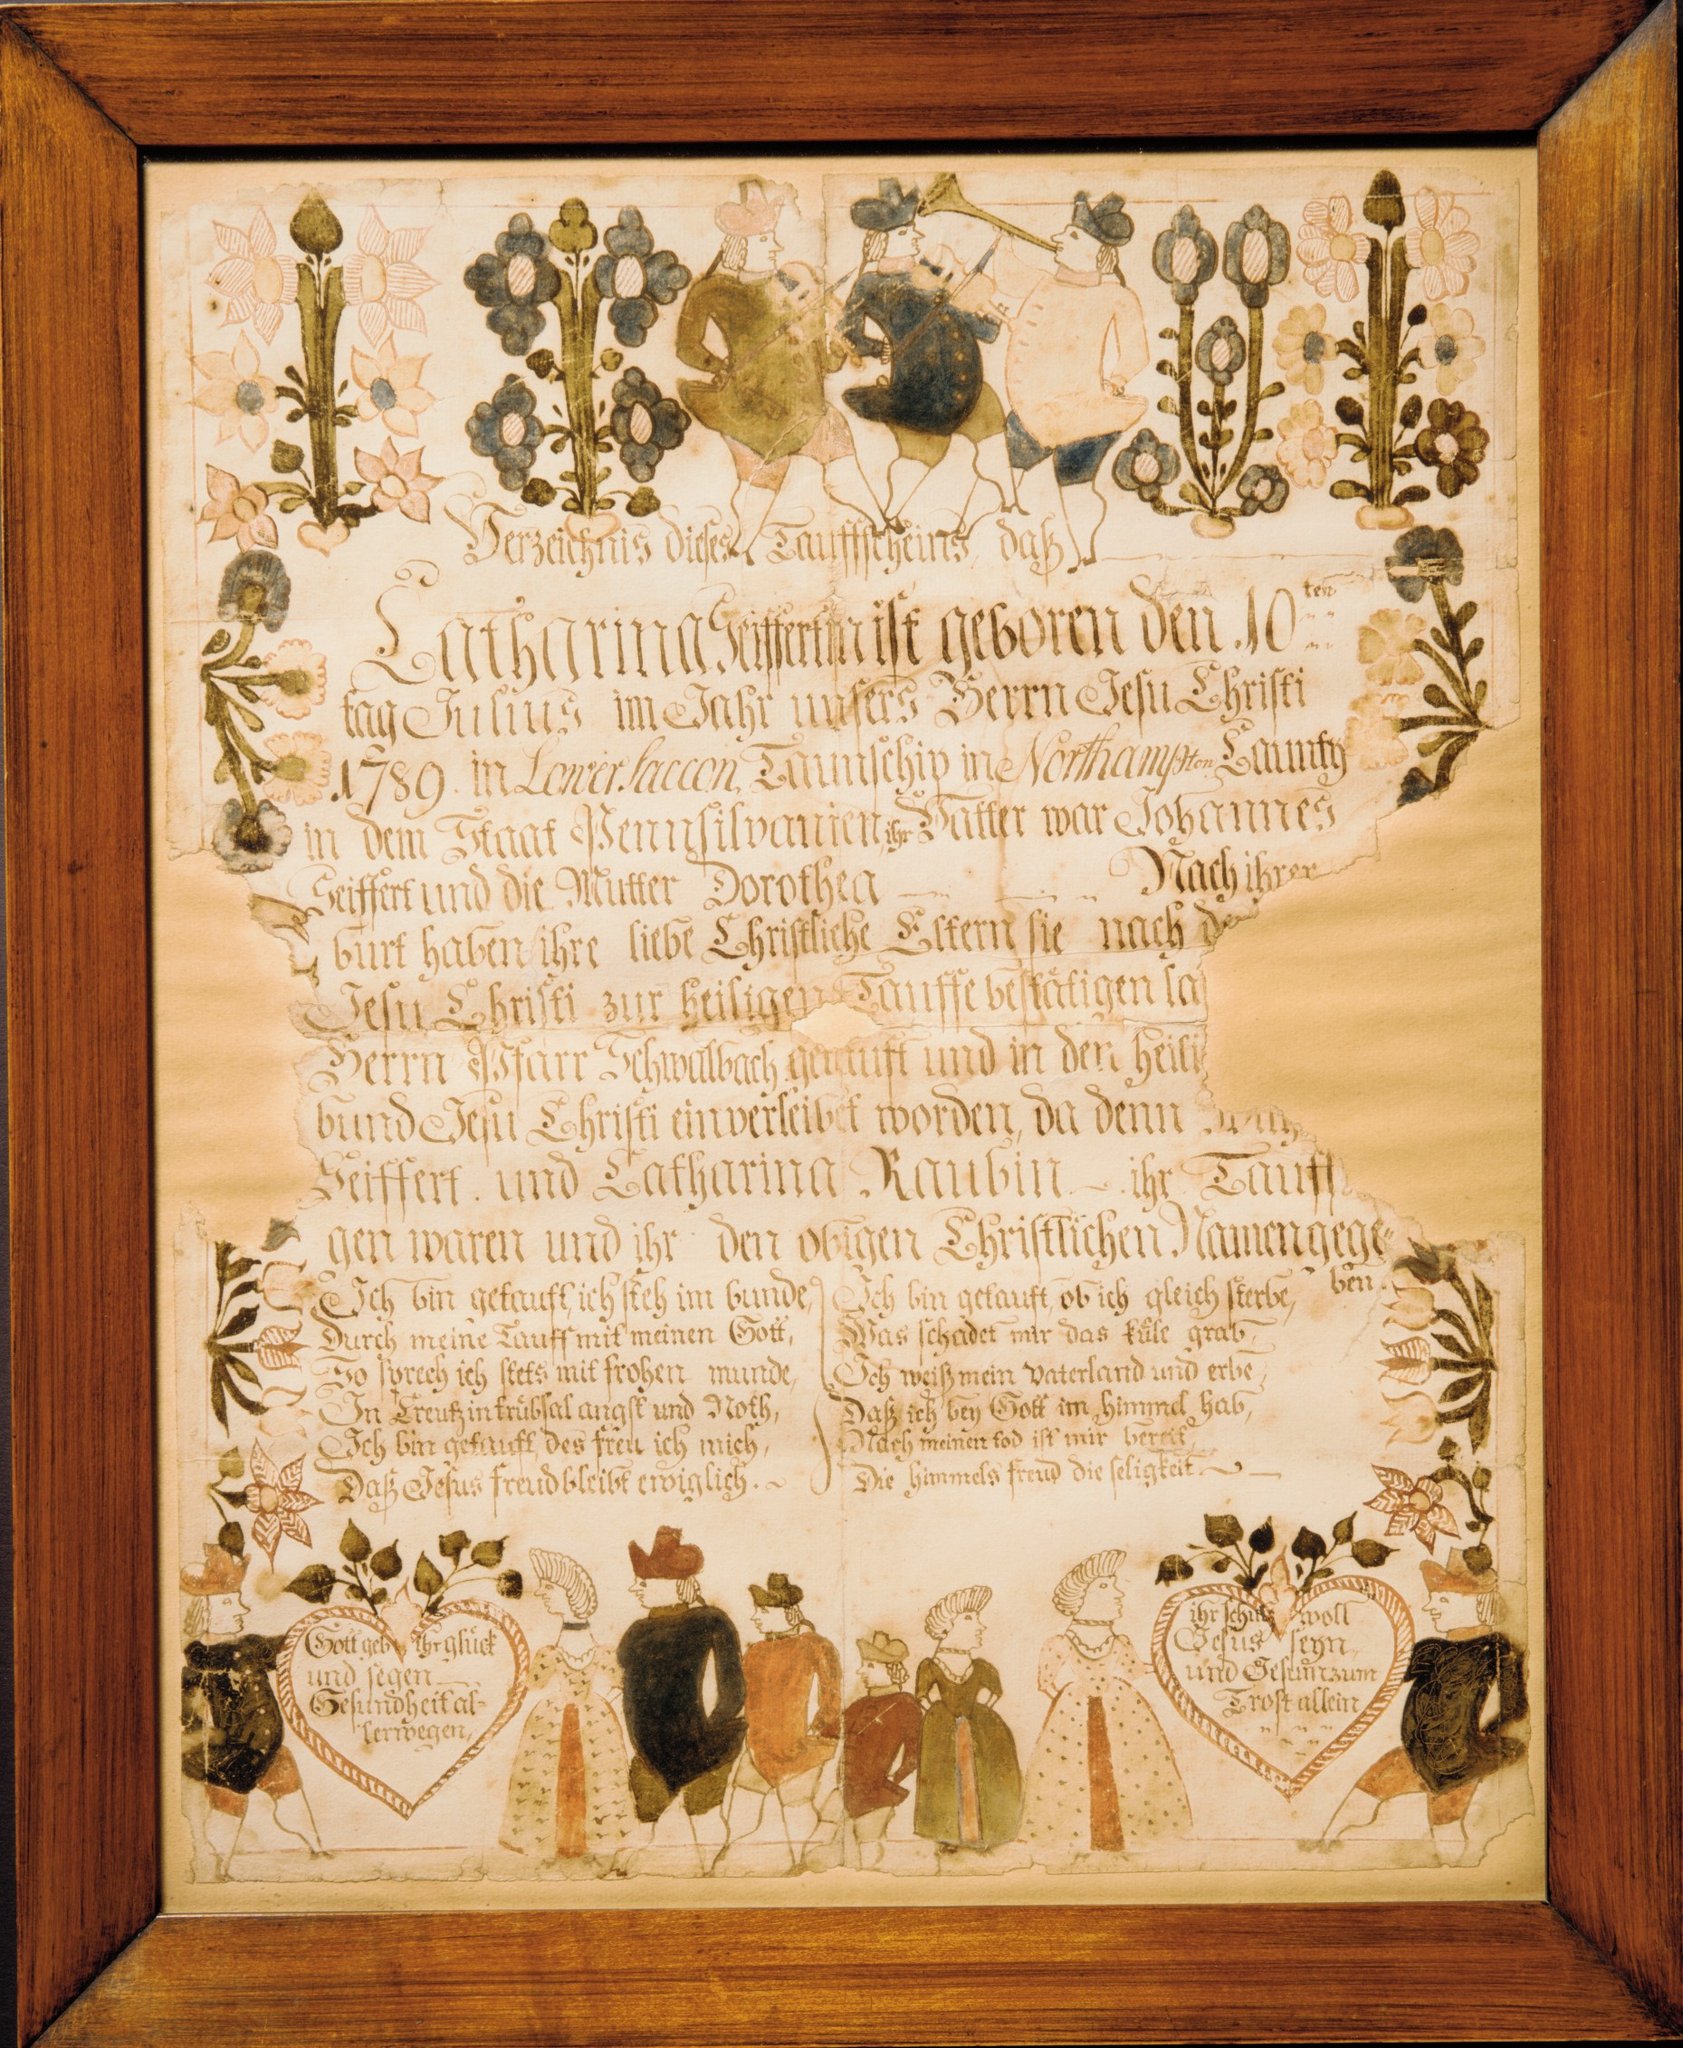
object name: birth and baptismal certificate, fraktur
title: Birth and Baptismal Certificate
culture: american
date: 1789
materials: ink, paper, watercolor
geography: united states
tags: men,women